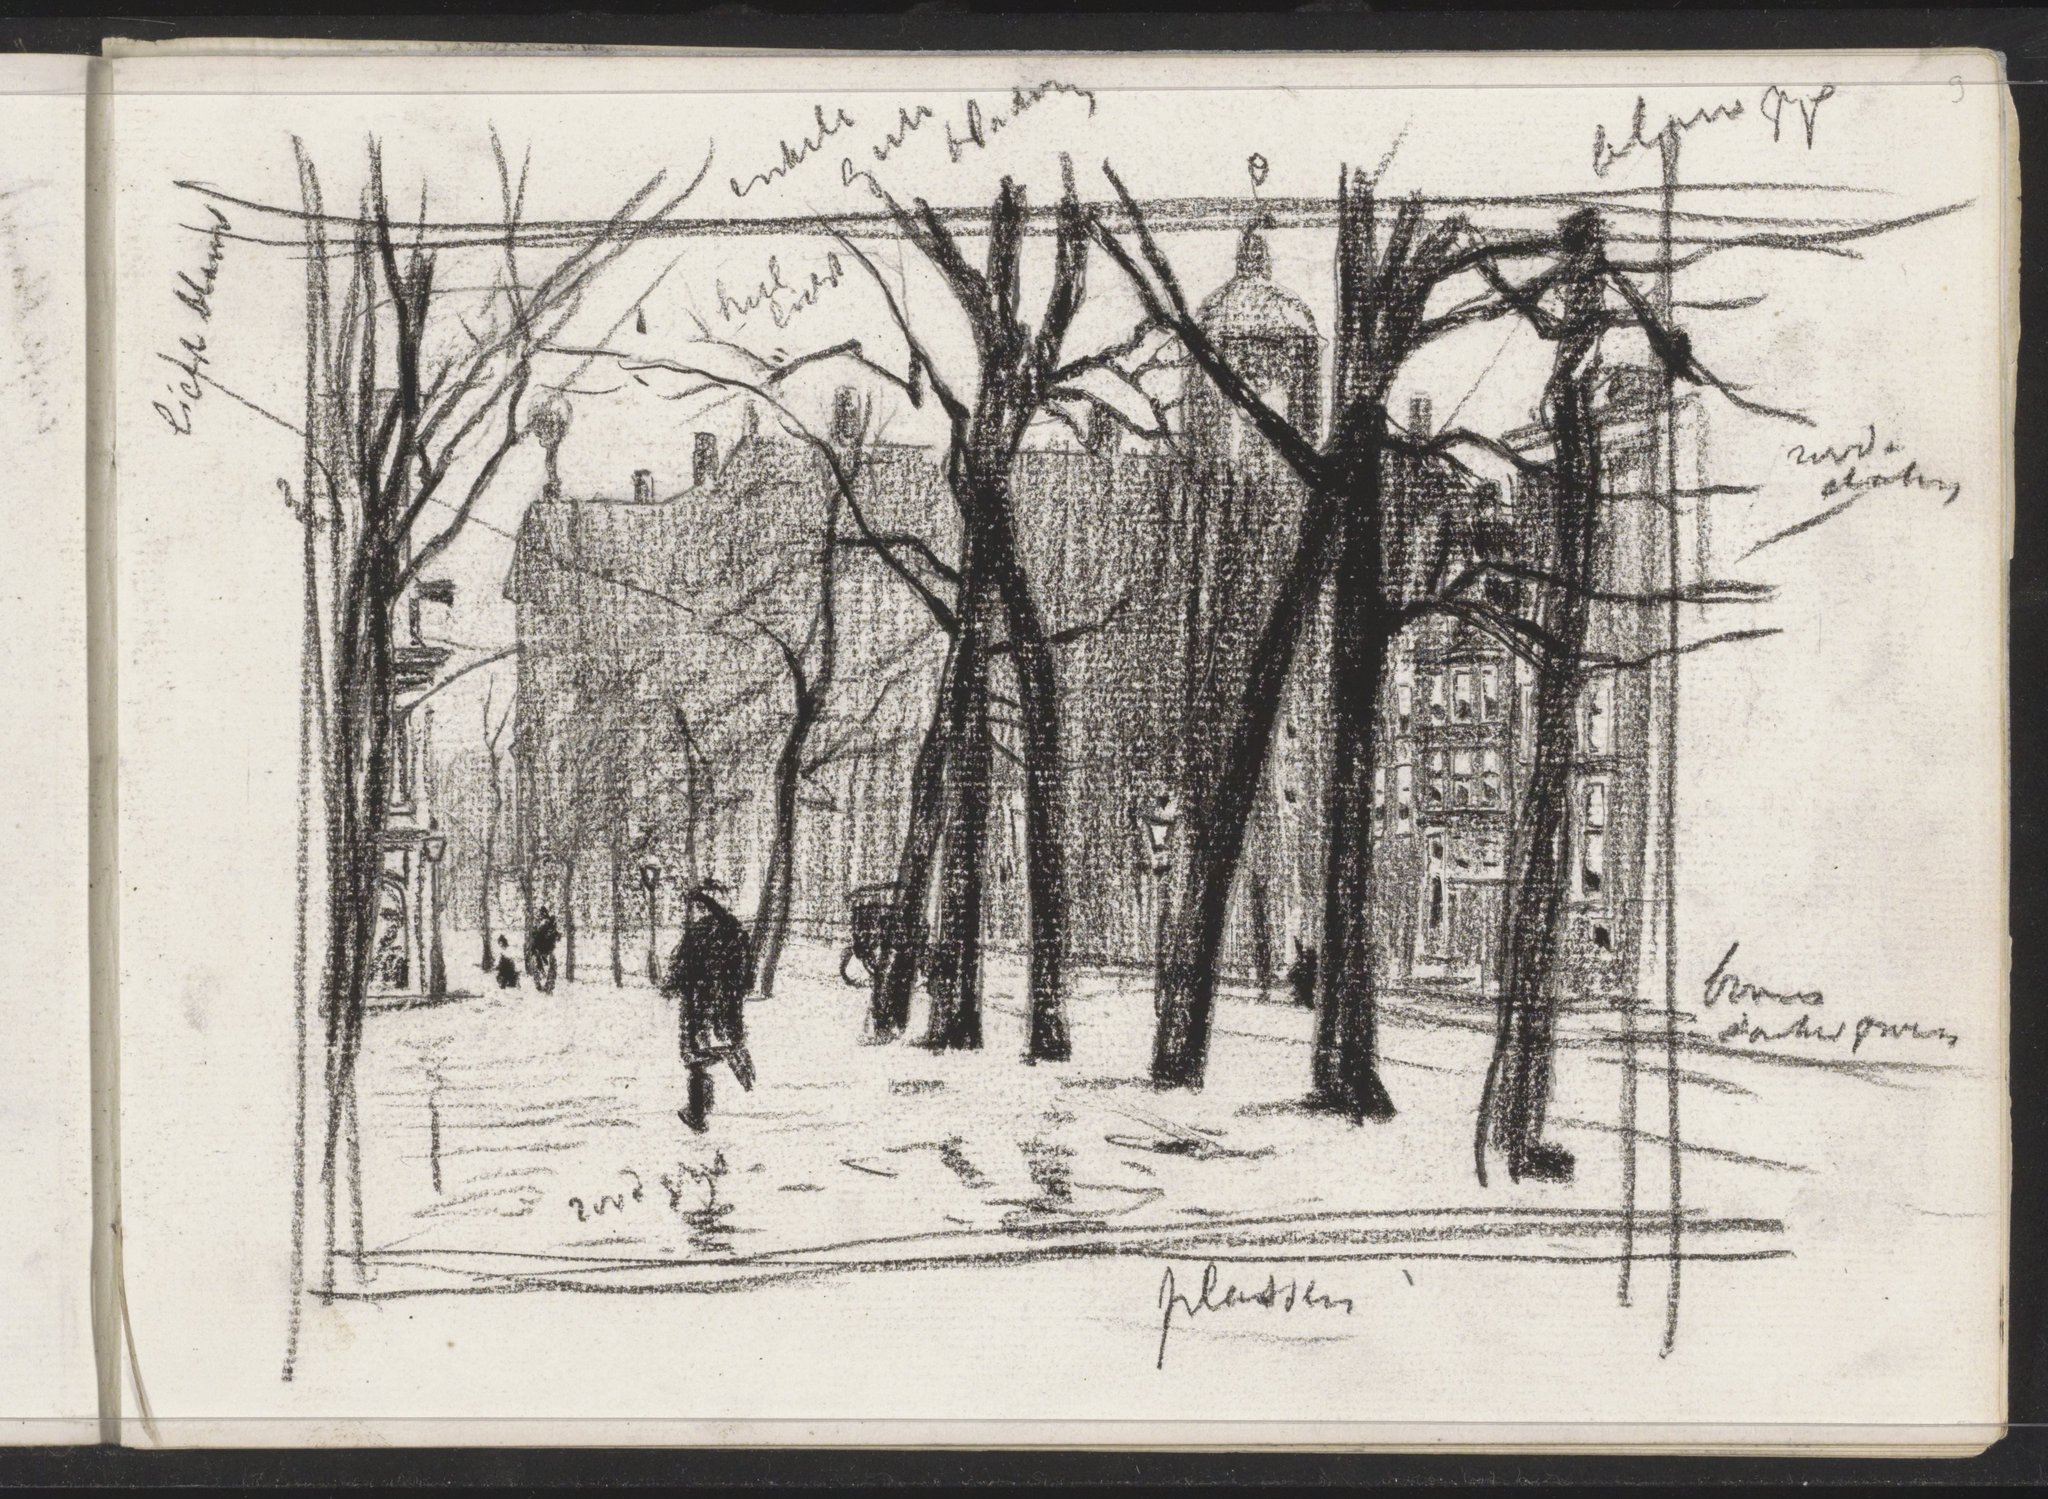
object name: sketchbook leaf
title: Gezicht op de Nieuwezijds Voorburgwal met het Koninklijk Paleis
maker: willem witsen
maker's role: draughtsman, painter, print maker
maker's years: 1860-1923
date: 1897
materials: chalk, paper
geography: amsterdam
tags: street (+ city(-scape) with figures, staffage), royal palace of amsterdam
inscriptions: kleurnotitie, handgeschreven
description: Pagina 9 uit een schetsboek met 17 bladen.